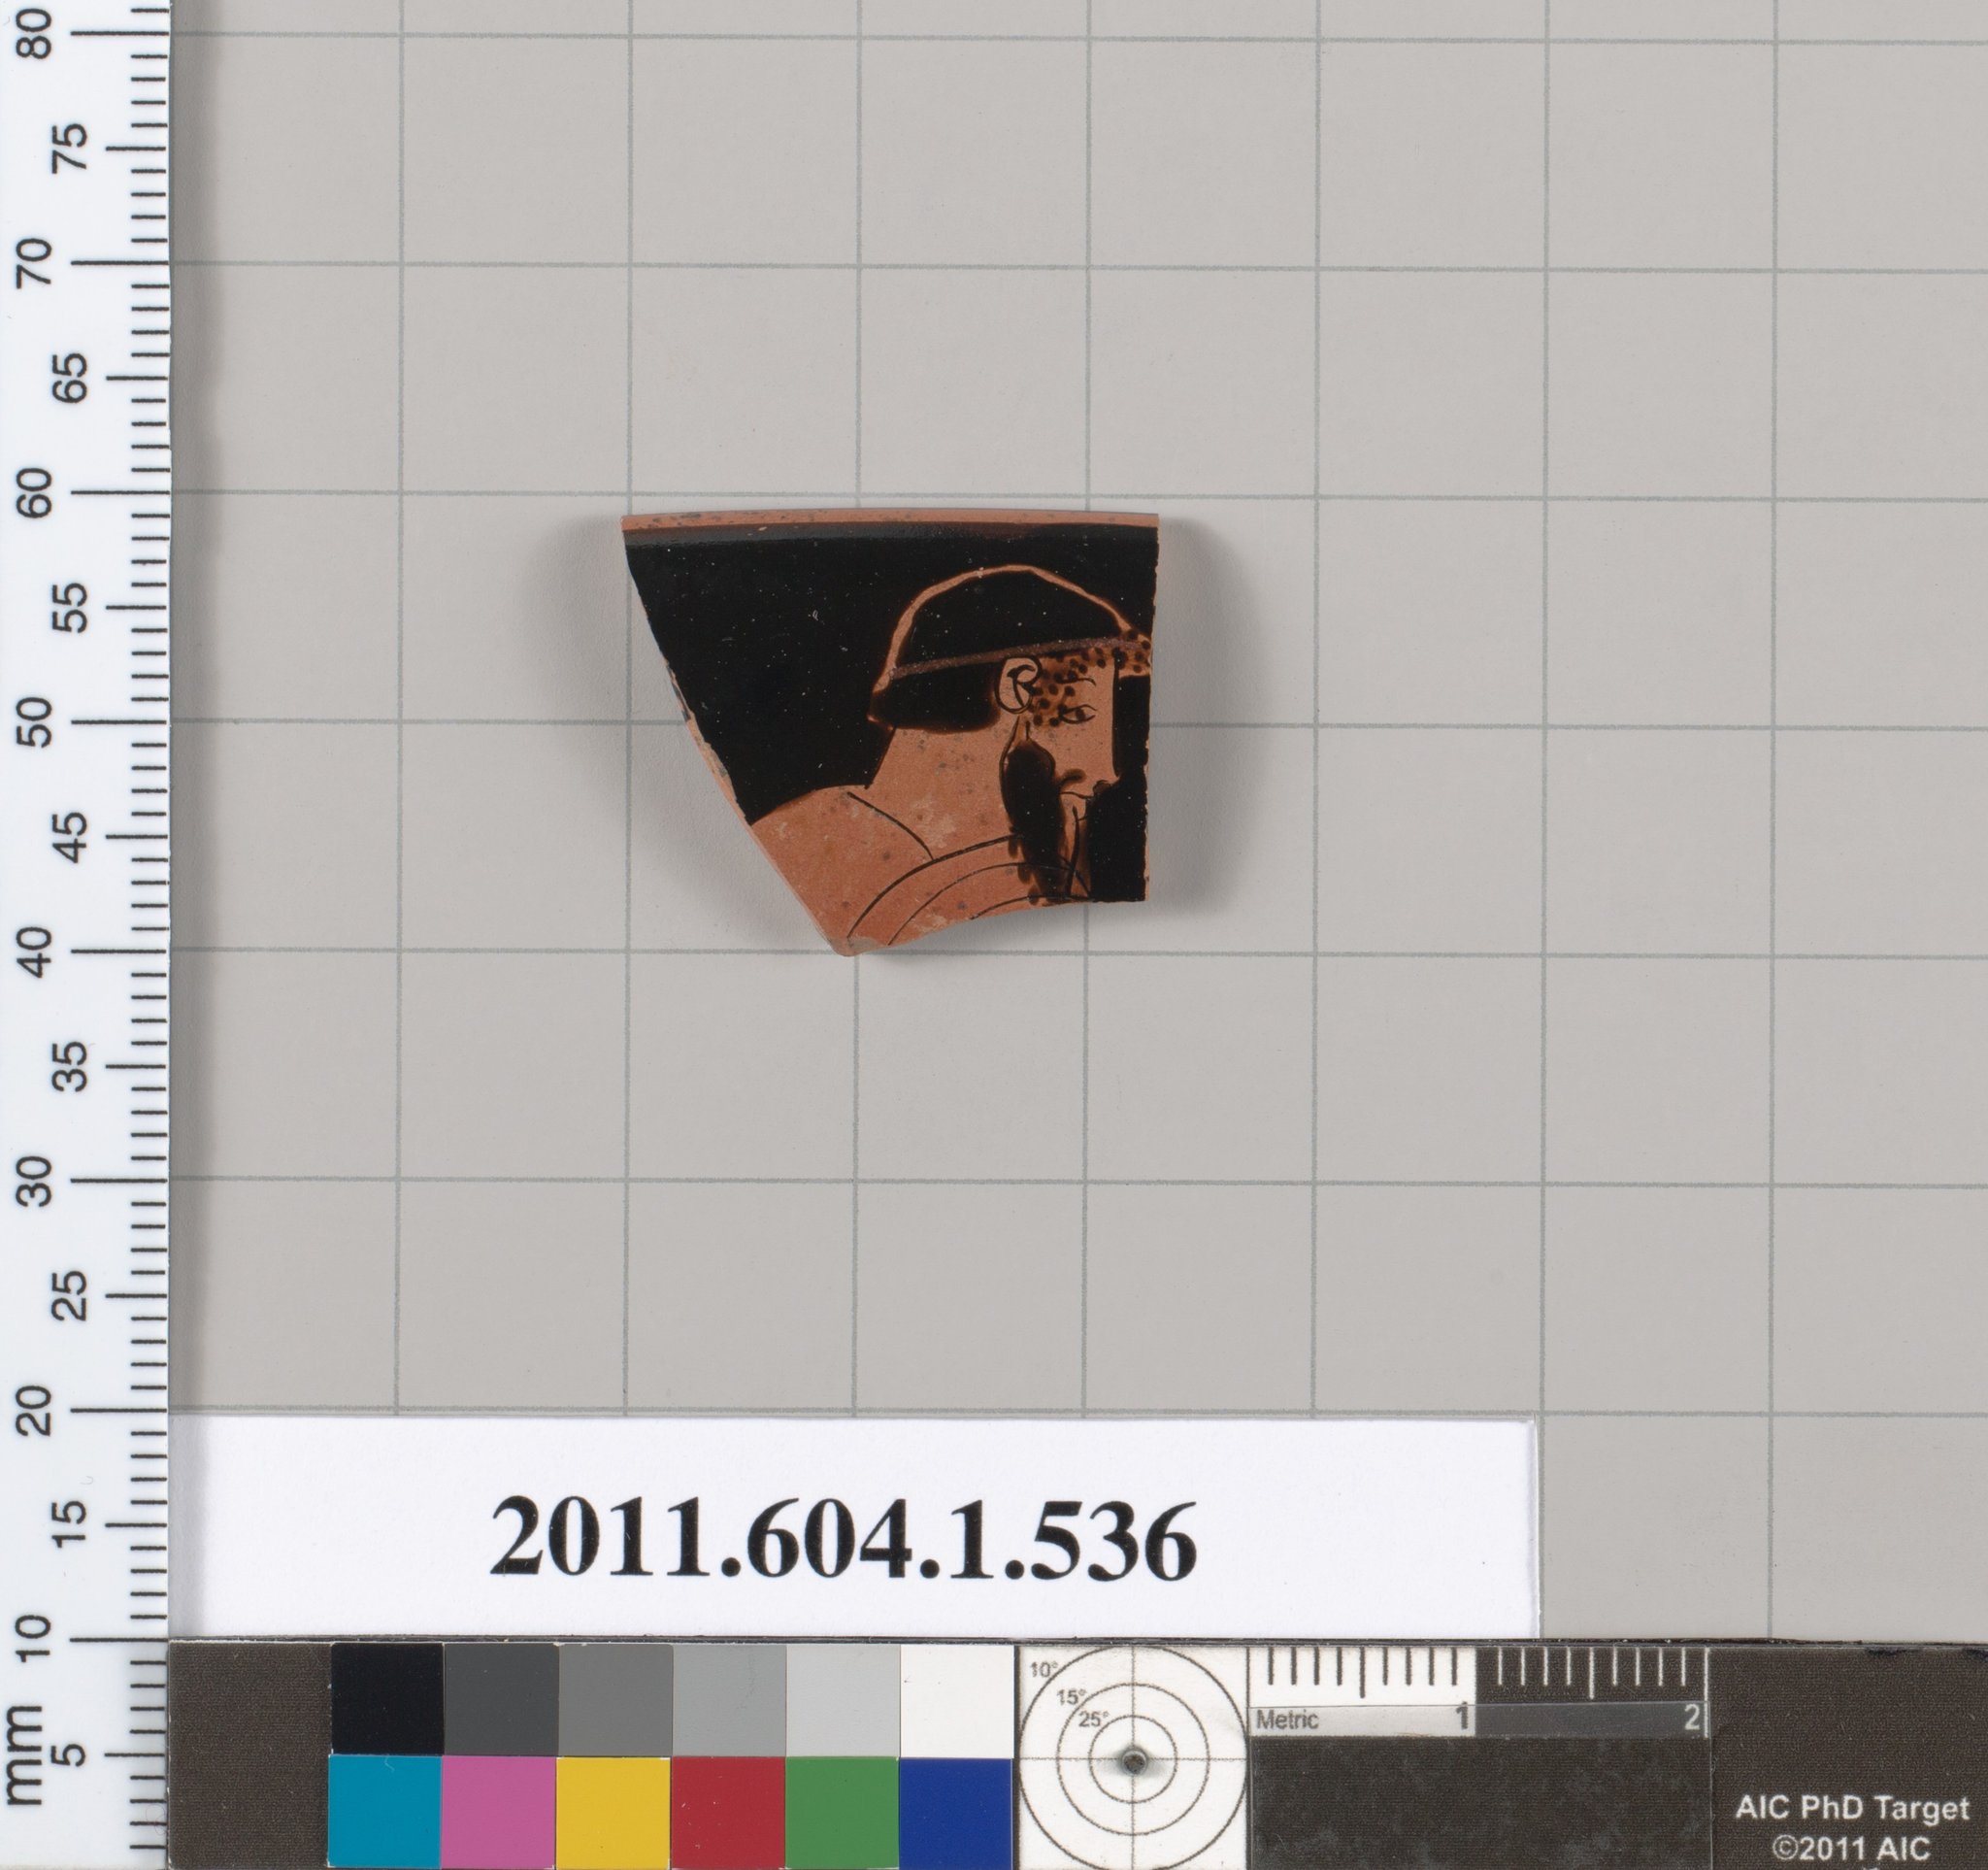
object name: kylix fragment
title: Terracotta rim fragment of a kylix (drinking cup)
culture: greek, attic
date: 480-470 BCE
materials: terracotta